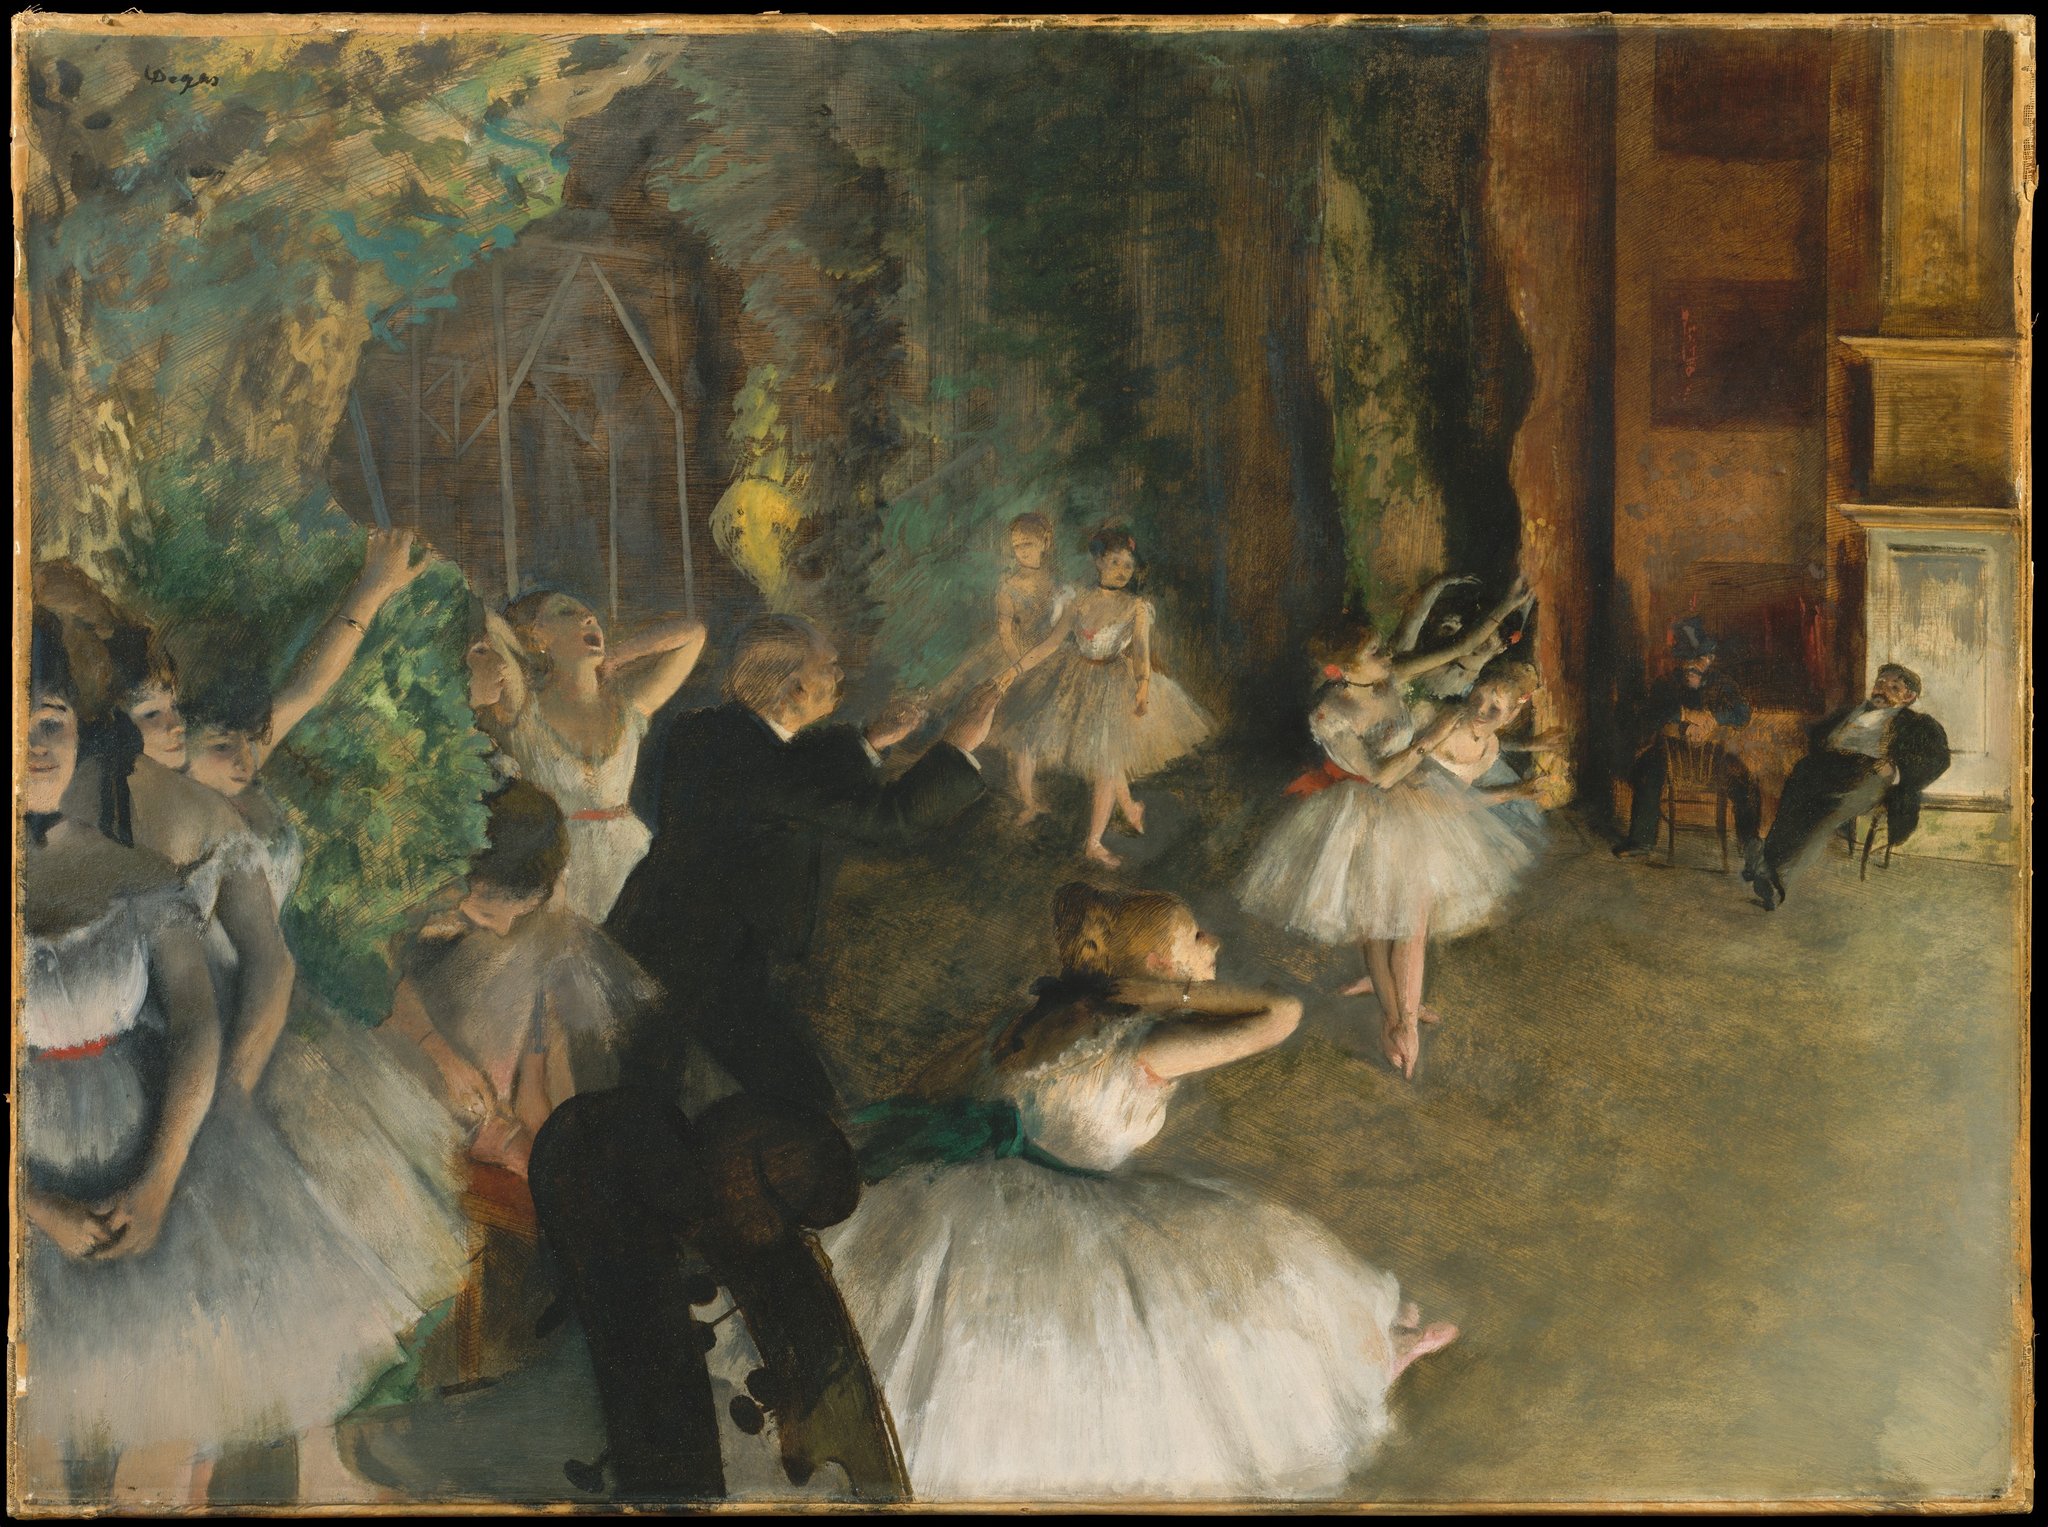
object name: drawing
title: The Rehearsal of the Ballet Onstage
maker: edgar degas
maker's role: artist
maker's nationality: french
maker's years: 1834-1917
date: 1874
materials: board, canvas, ink, oil, pastel, watercolor, paper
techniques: drawing, pen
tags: men,women,dancing,dancers,ballet